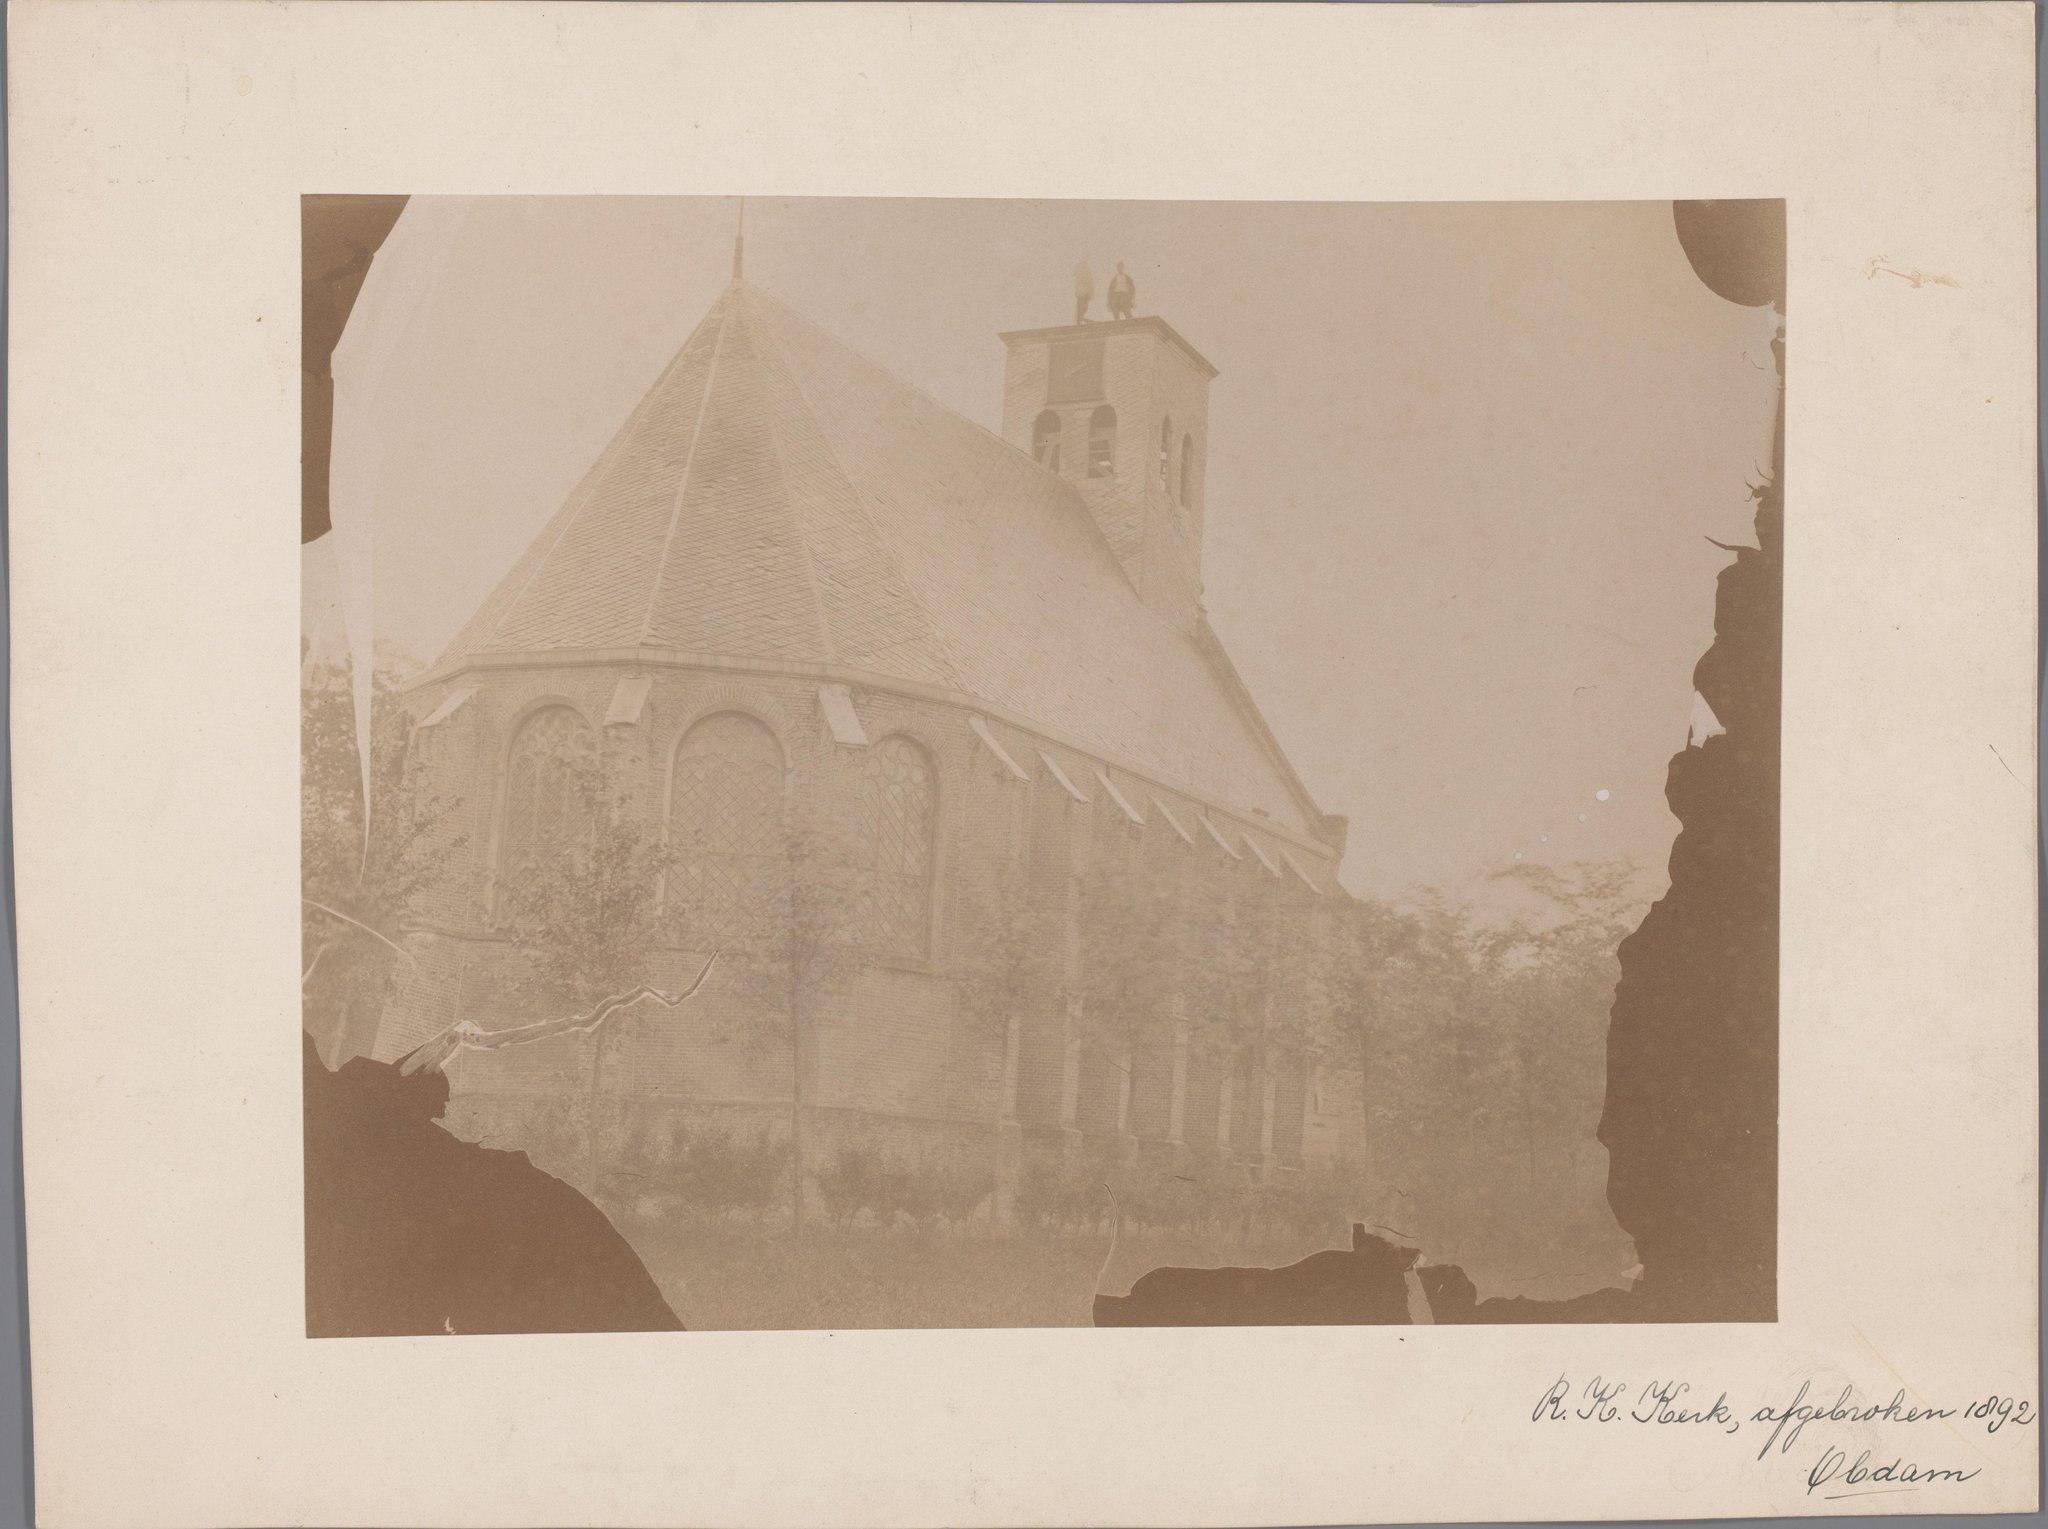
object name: photograph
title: Gezicht op de Rooms-Katholieke Kerk te Obdam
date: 1892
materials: cardboard, photographic support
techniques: albumen print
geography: obdam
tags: church (exterior)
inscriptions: annotation: ‘R.K. Kerk, afgebroken 1892/ Obdam’, annotation: ‘Obdam N.H/ R.K. Kerk afgebroken 1892’